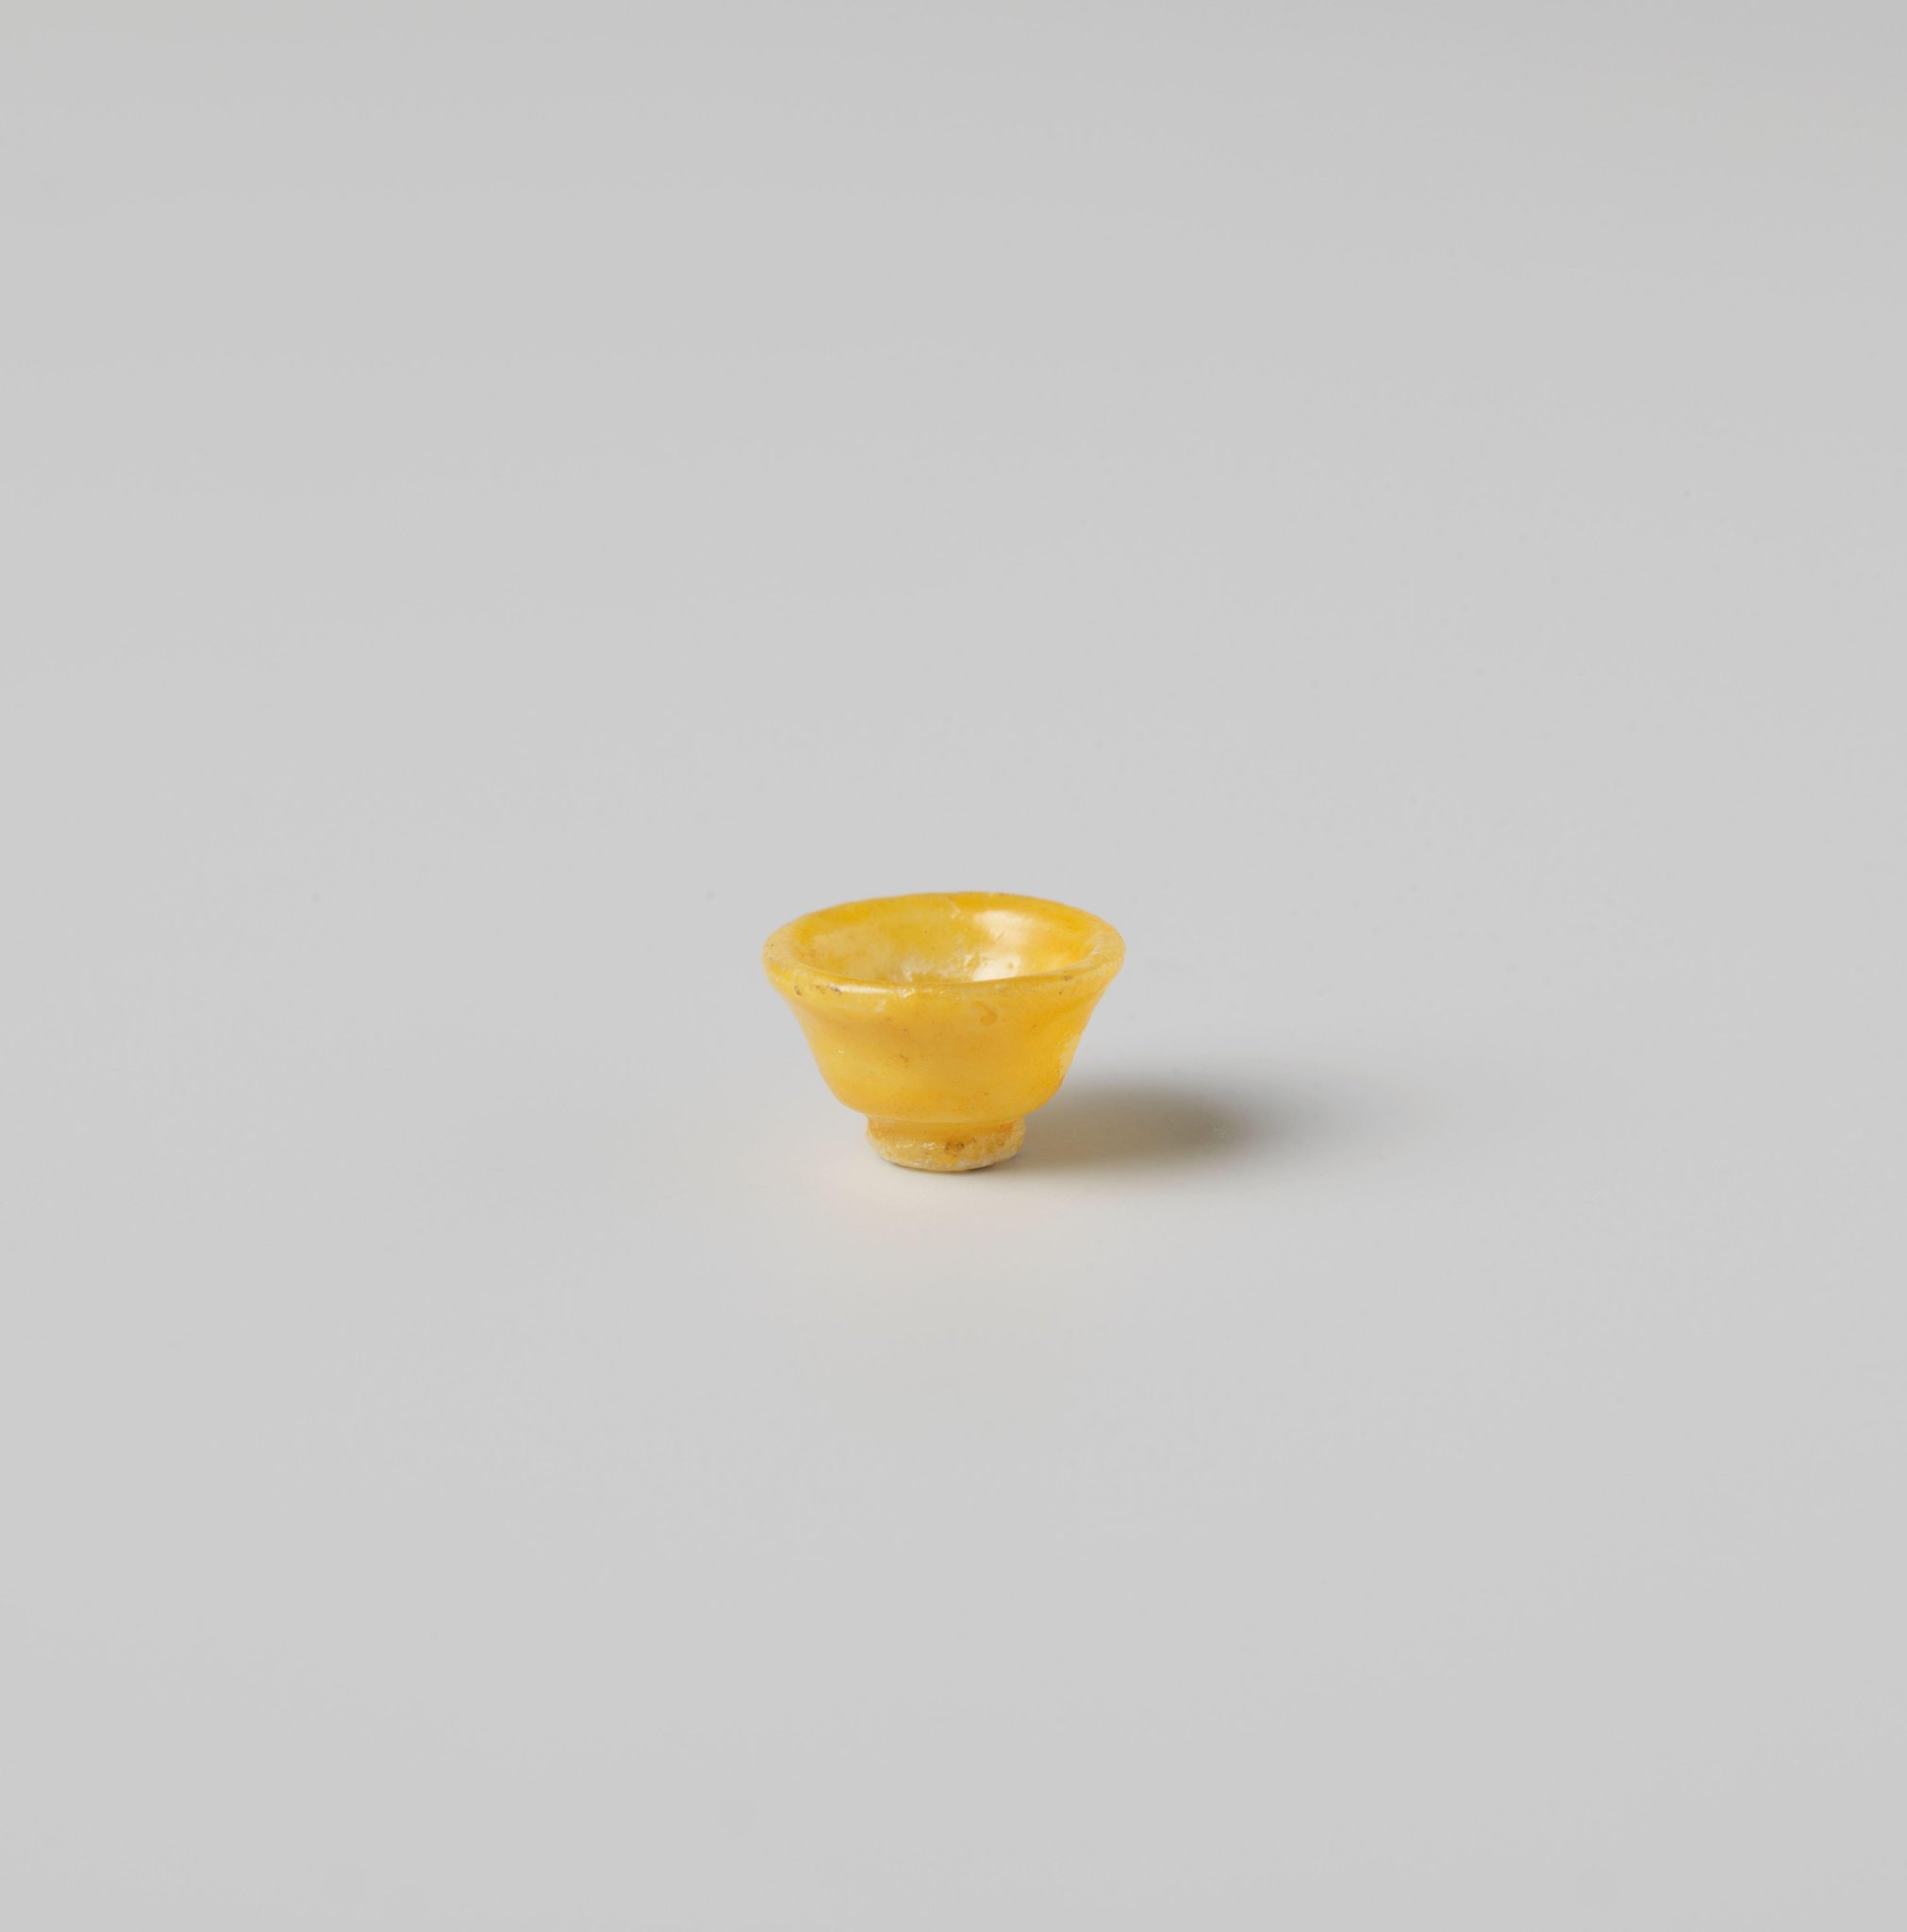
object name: cup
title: Kom, geelgelakt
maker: Anonymous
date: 1750-1800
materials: alabaster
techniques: lacquer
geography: germany